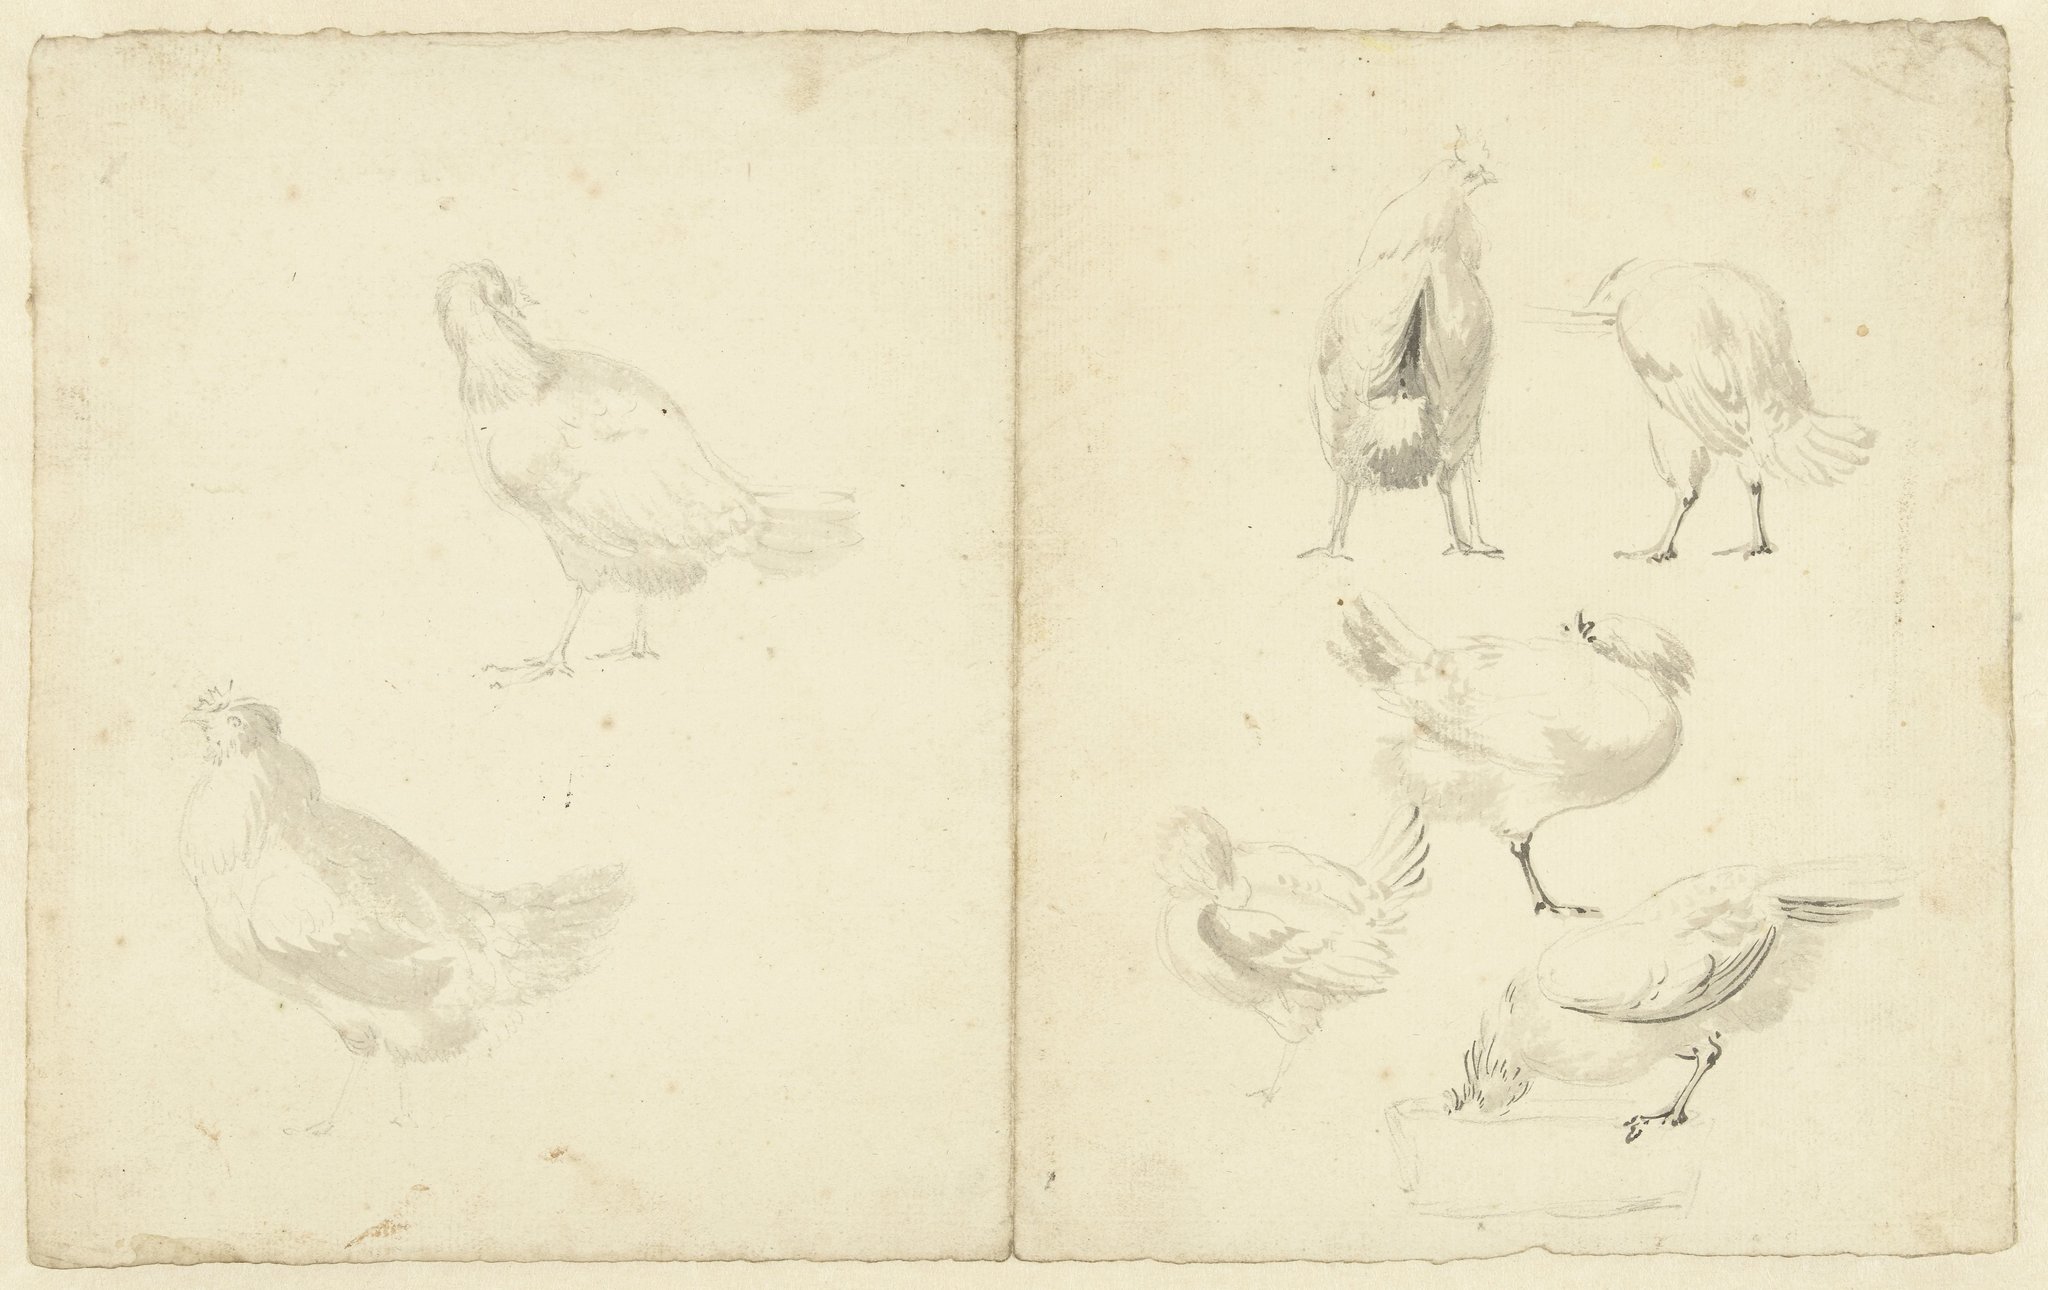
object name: drawing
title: Studieblad met zeven kippen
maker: aert schouman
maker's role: draughtsman, painter, print maker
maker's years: 1710-1792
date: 1720-1792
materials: ink, paper, pencil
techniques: brush, pen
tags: fowl (cock, hen, chicken, etc.) (+ female animal)